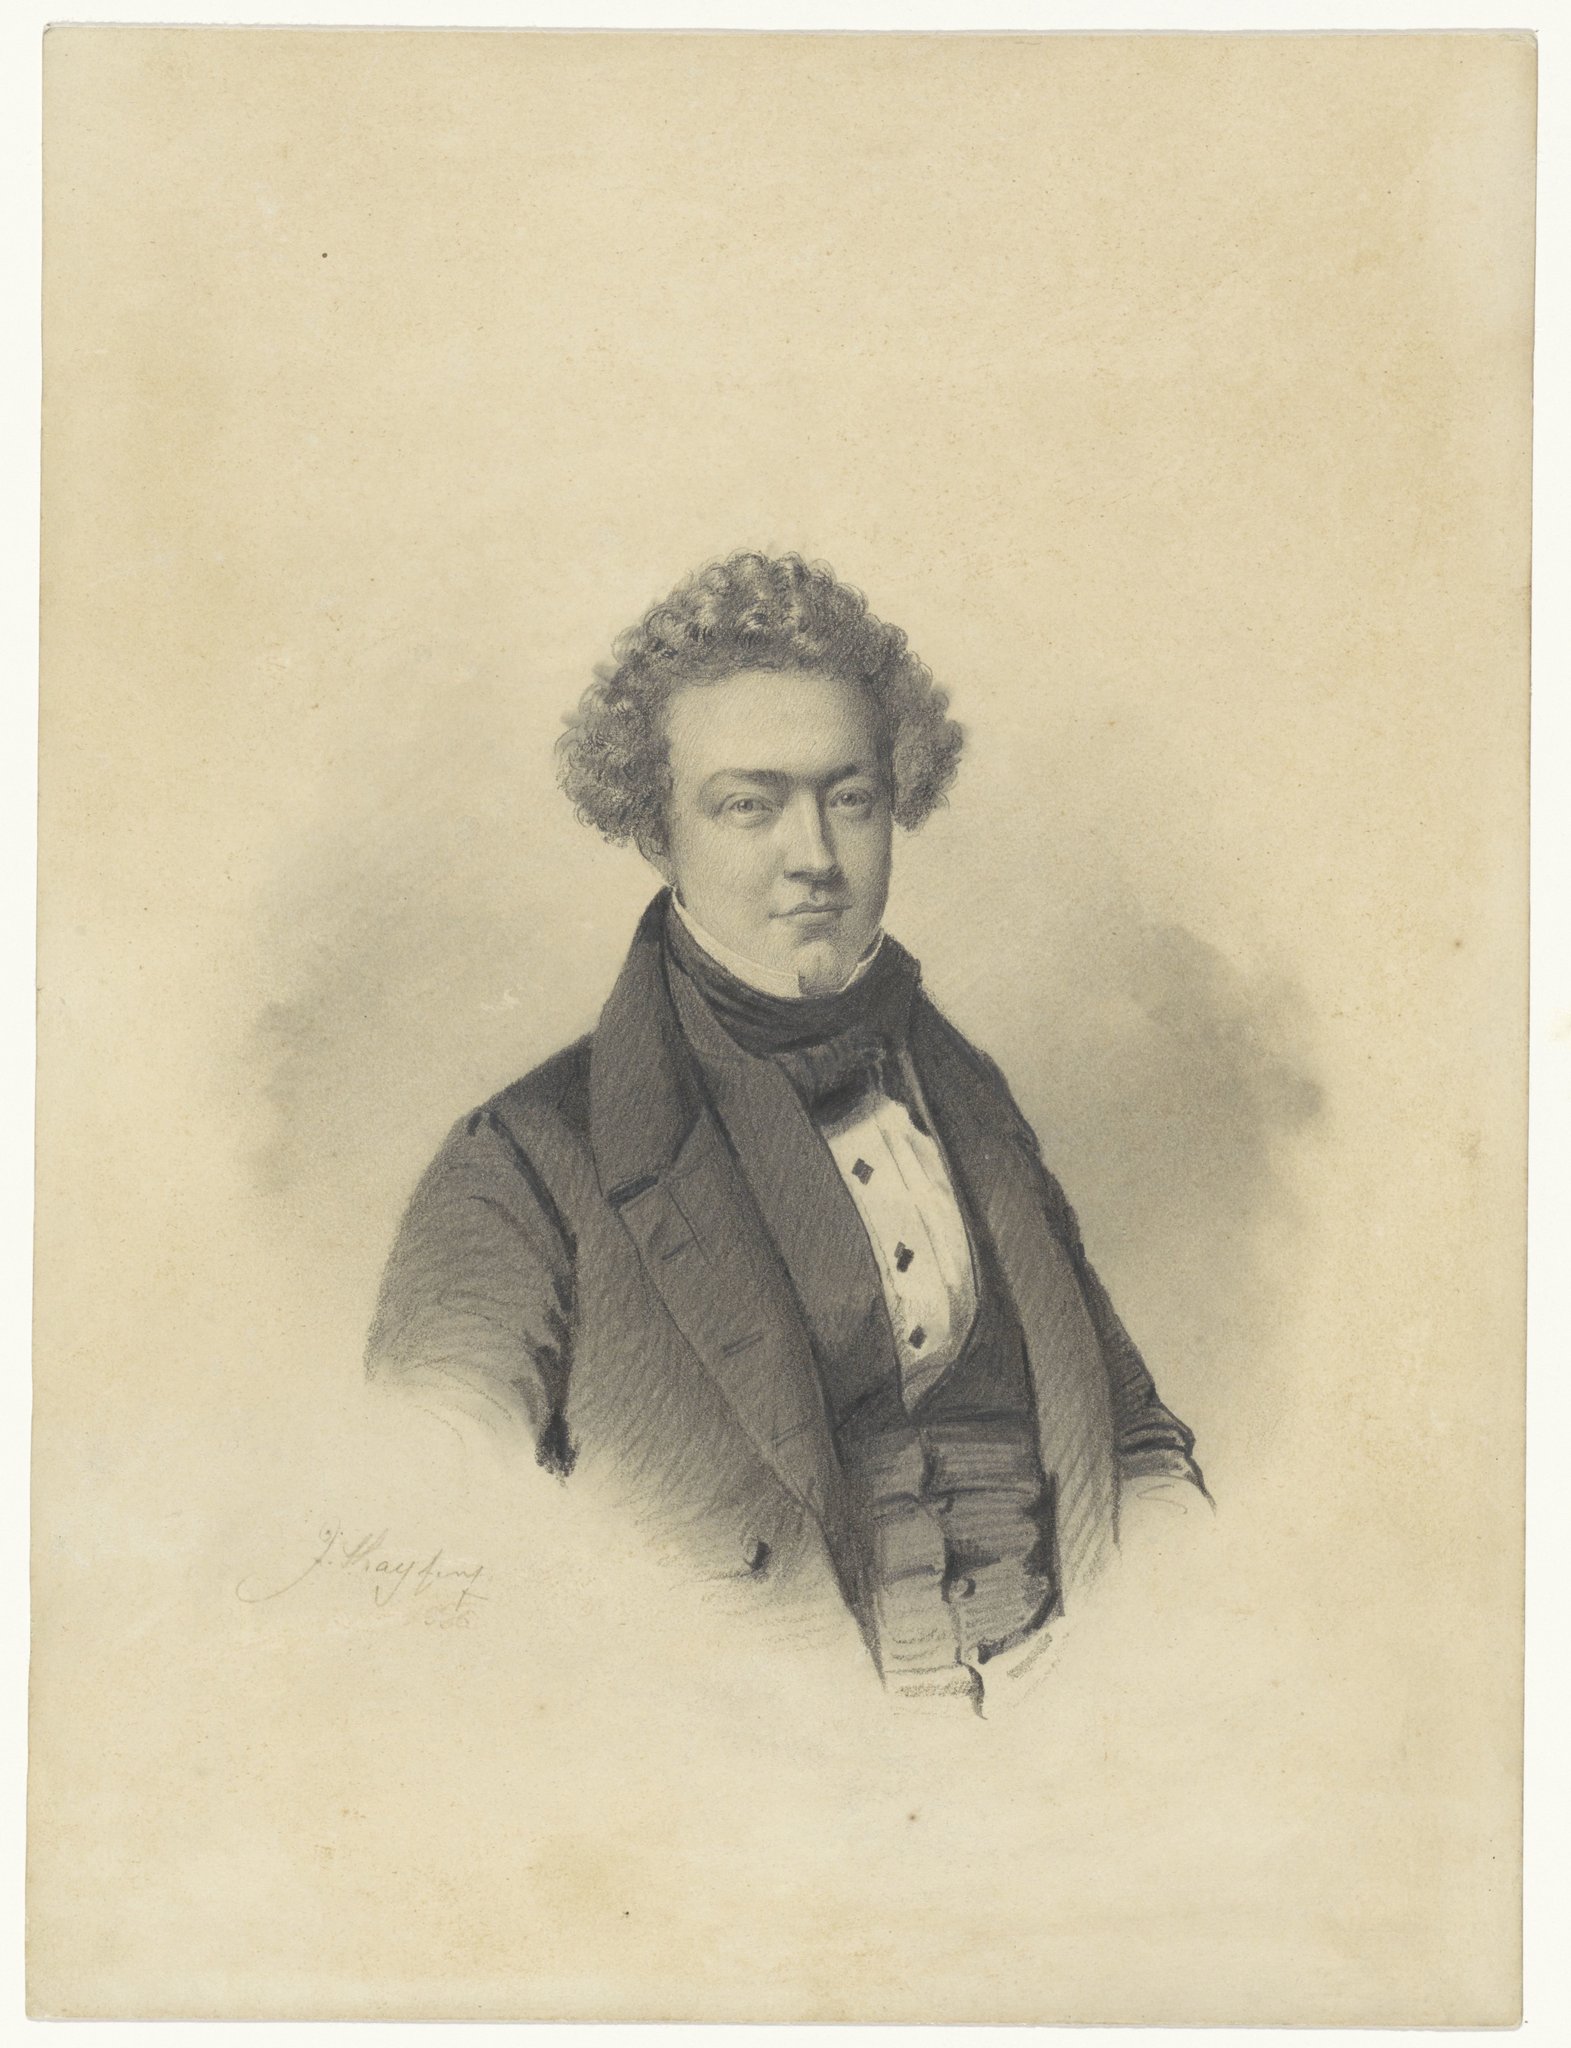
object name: drawing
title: Portret van een man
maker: joseph kayser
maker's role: draughtsman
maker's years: 1803-1900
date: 1836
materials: paper, pencil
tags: anonymous historical person portrayed alone